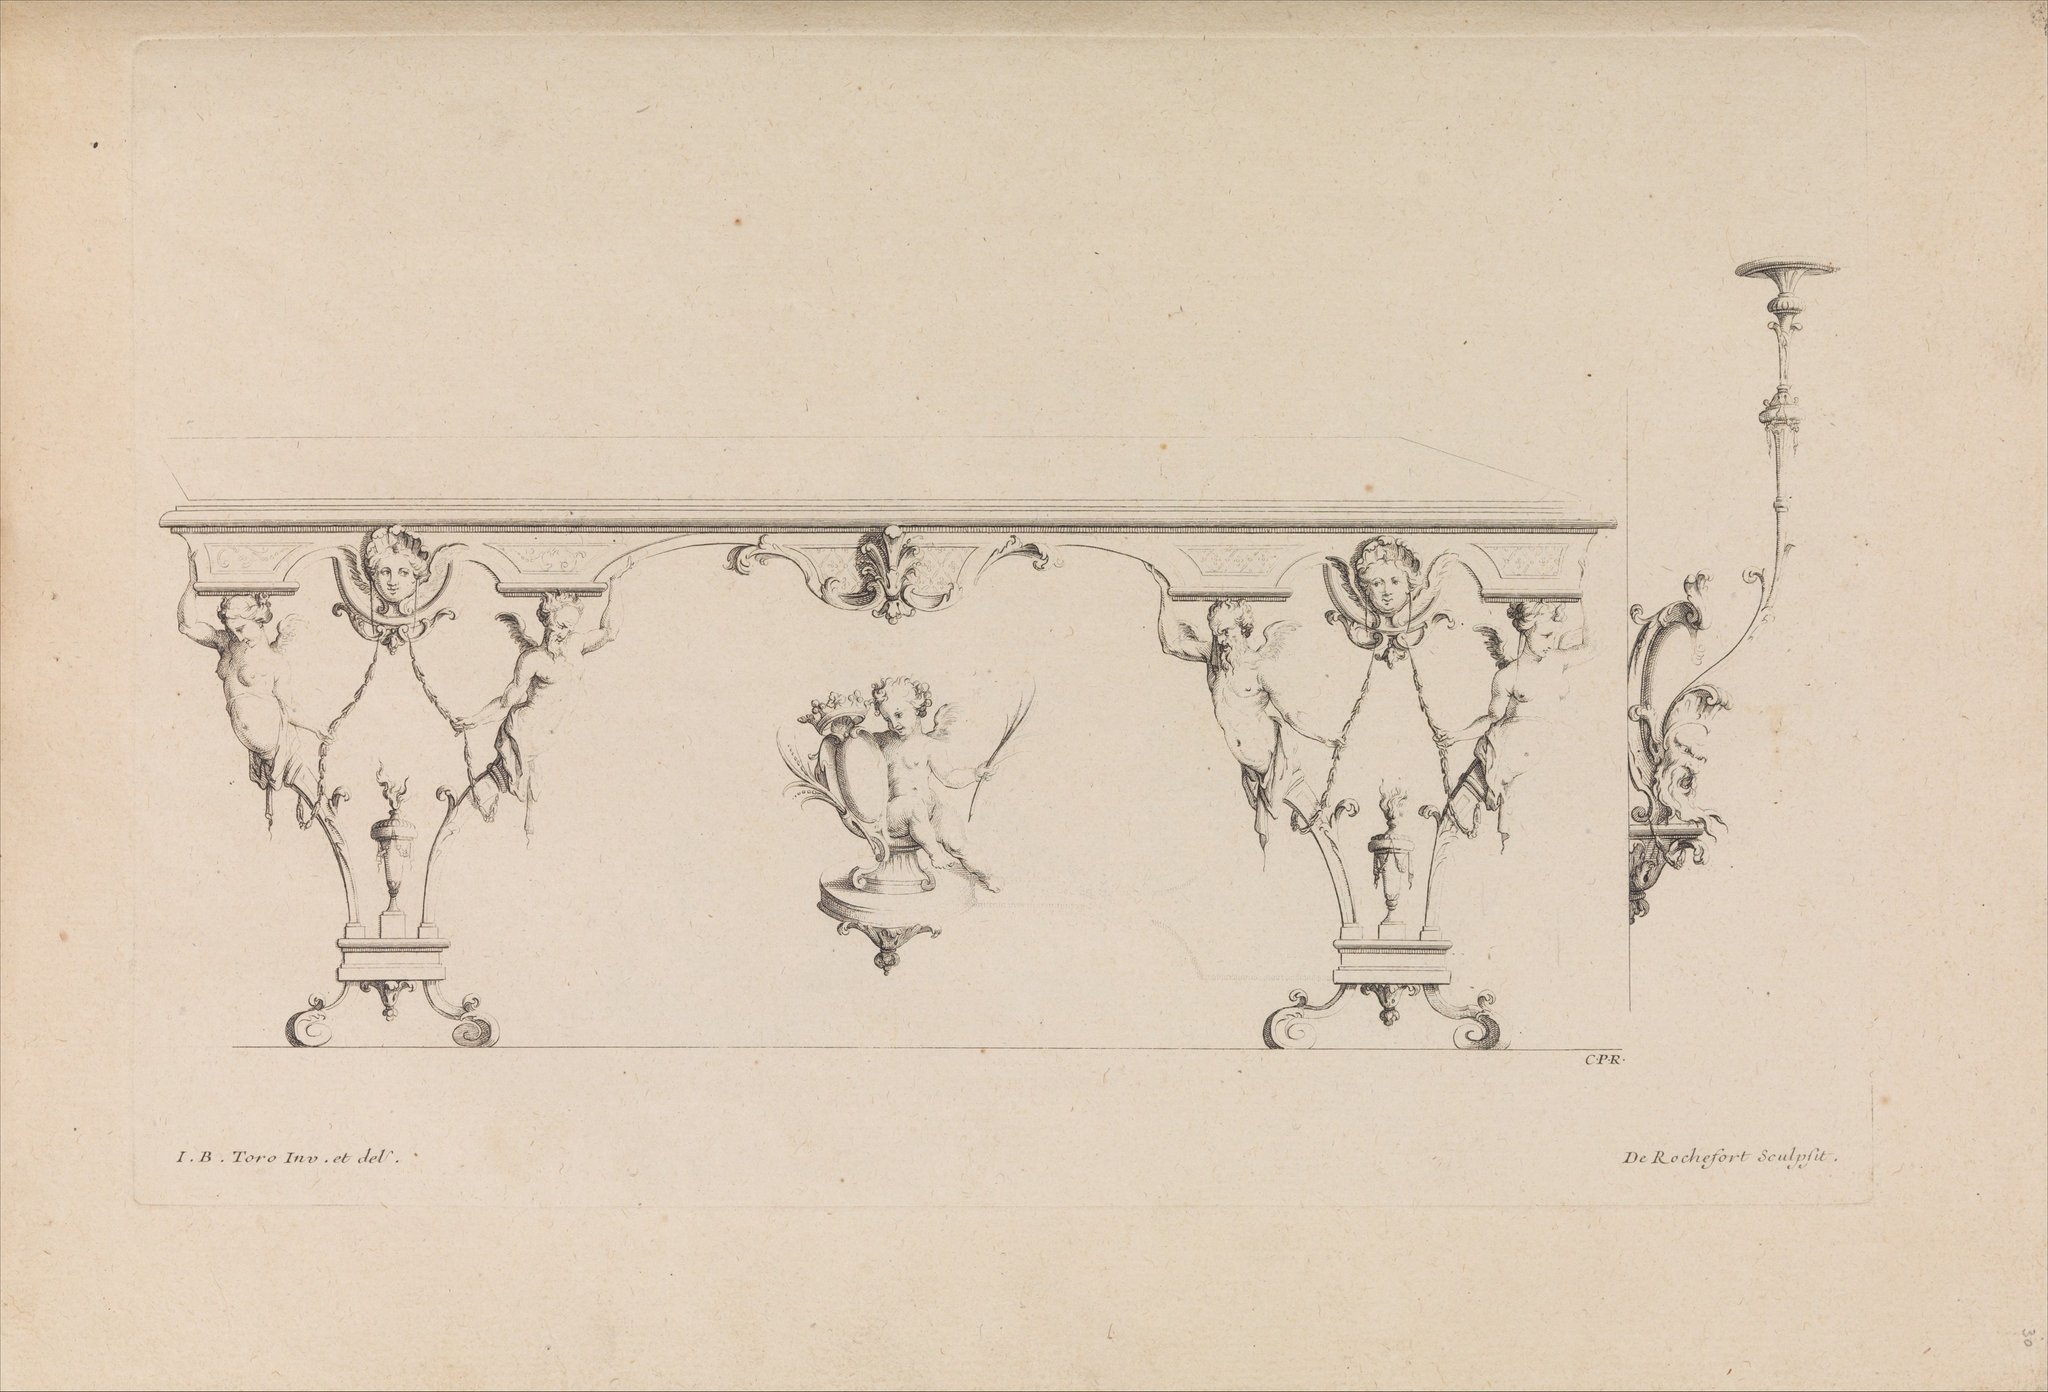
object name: album print ornament architecture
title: Livre de Tables de Diverses Formes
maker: jean bernard toro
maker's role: designer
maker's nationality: french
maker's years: 1672-1731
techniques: etching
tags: faces,tables